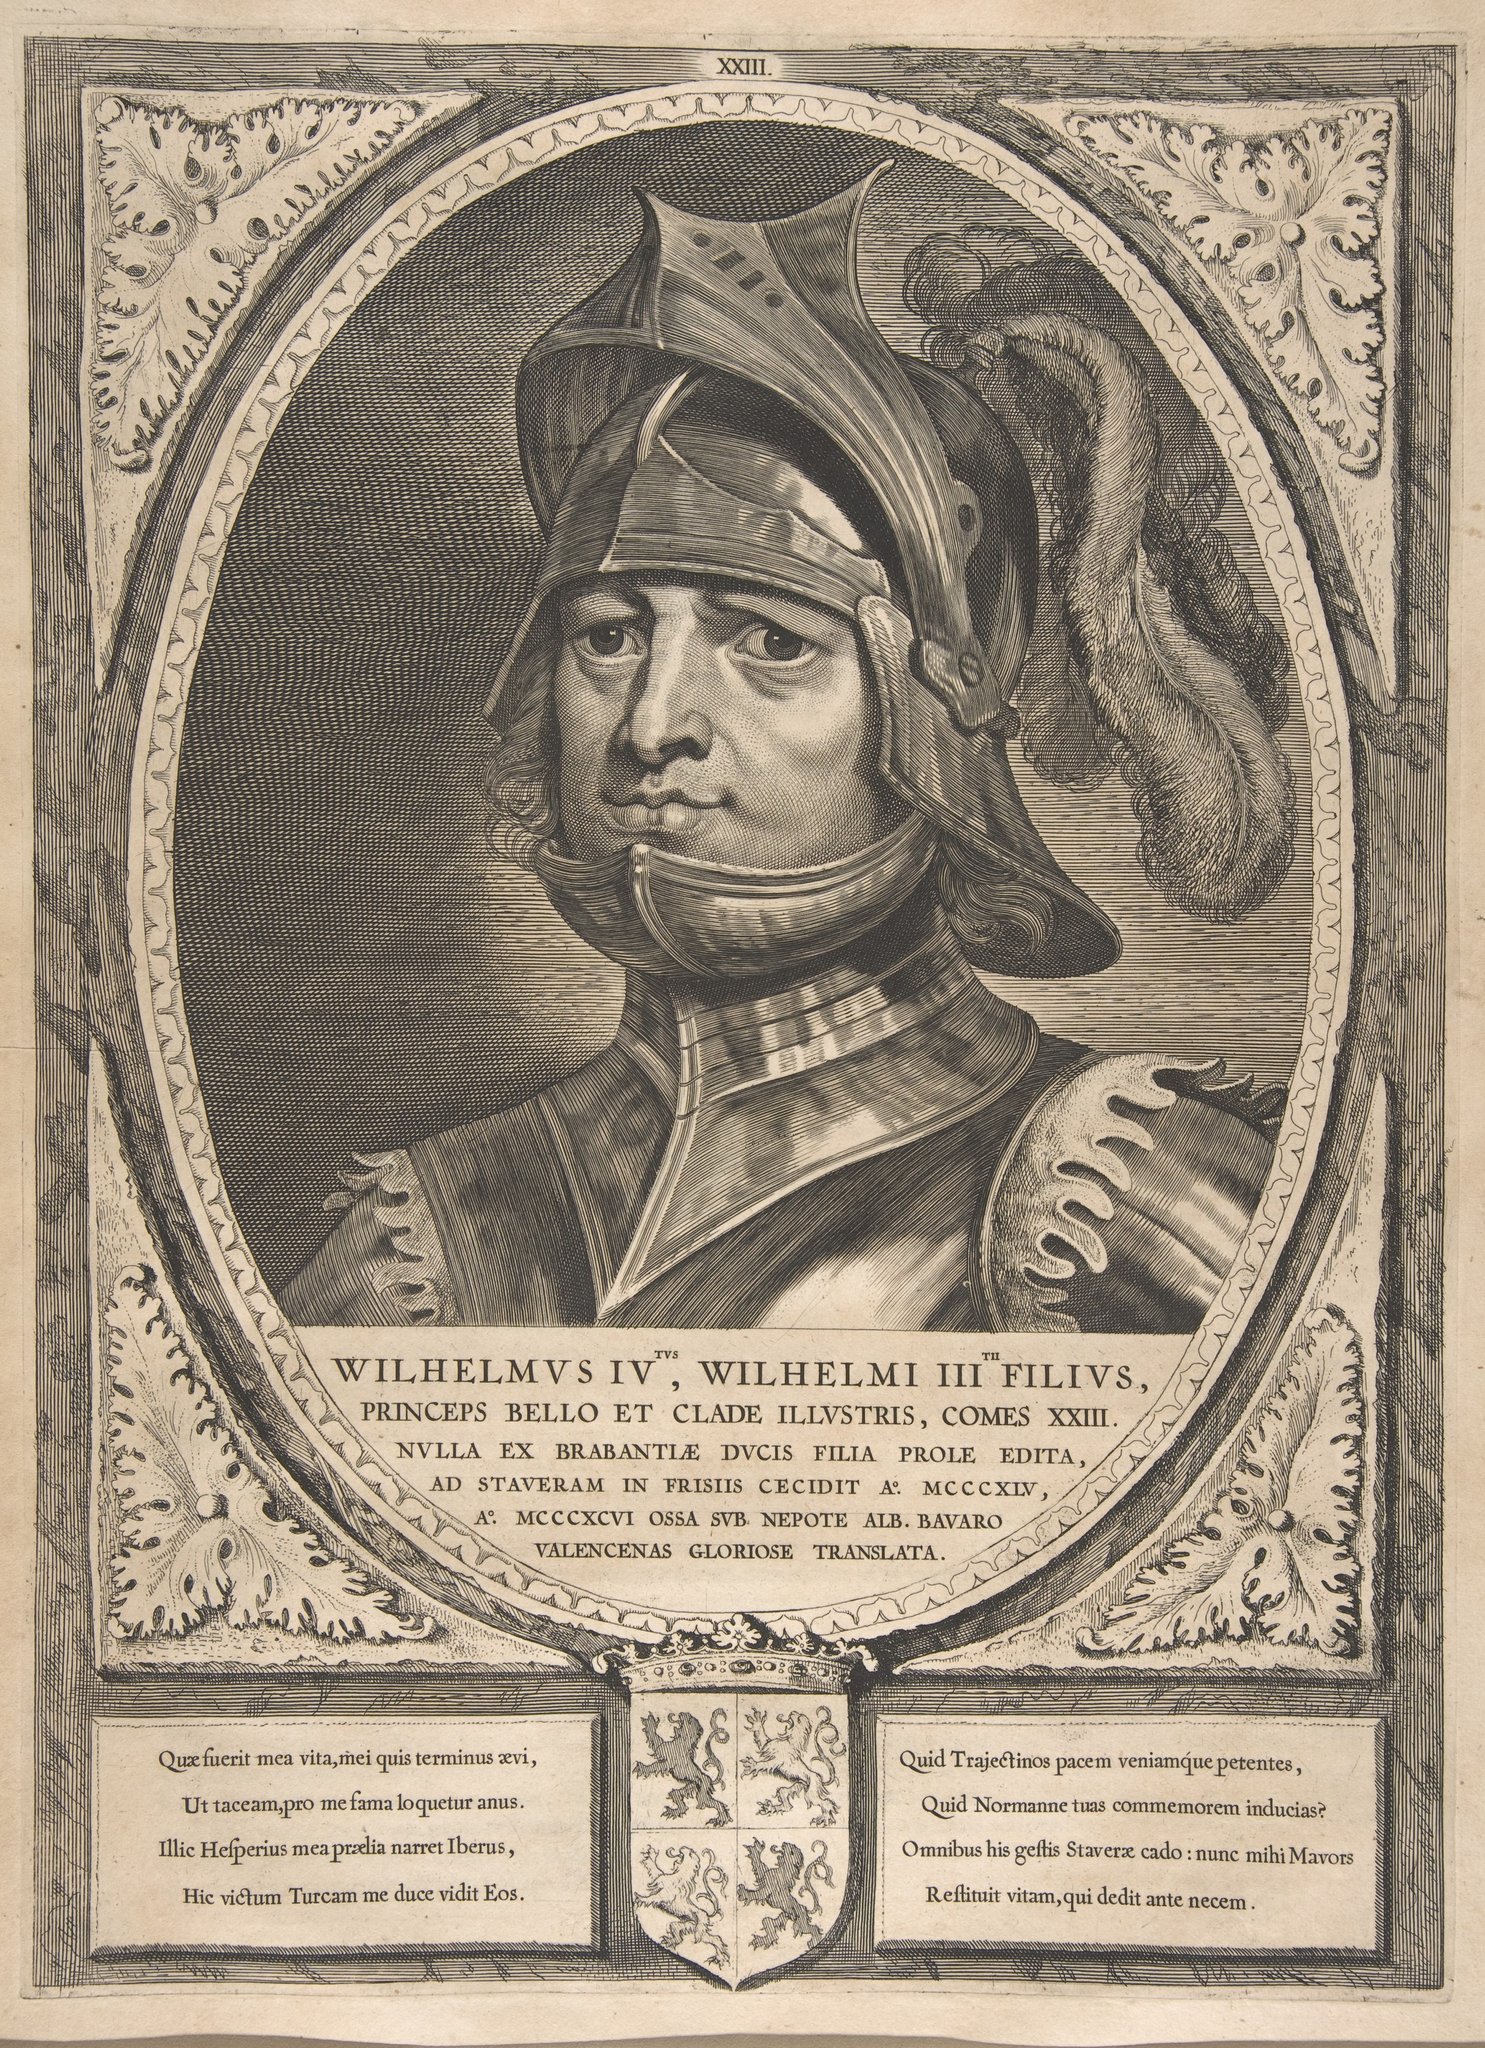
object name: print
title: William IV from the series Counts and Countesses of Holland, Zeeland, and West-Frisia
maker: pieter soutman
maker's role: artist and publisher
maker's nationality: dutch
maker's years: 1580-1657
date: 1650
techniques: engraving, etching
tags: armor,men,portraits